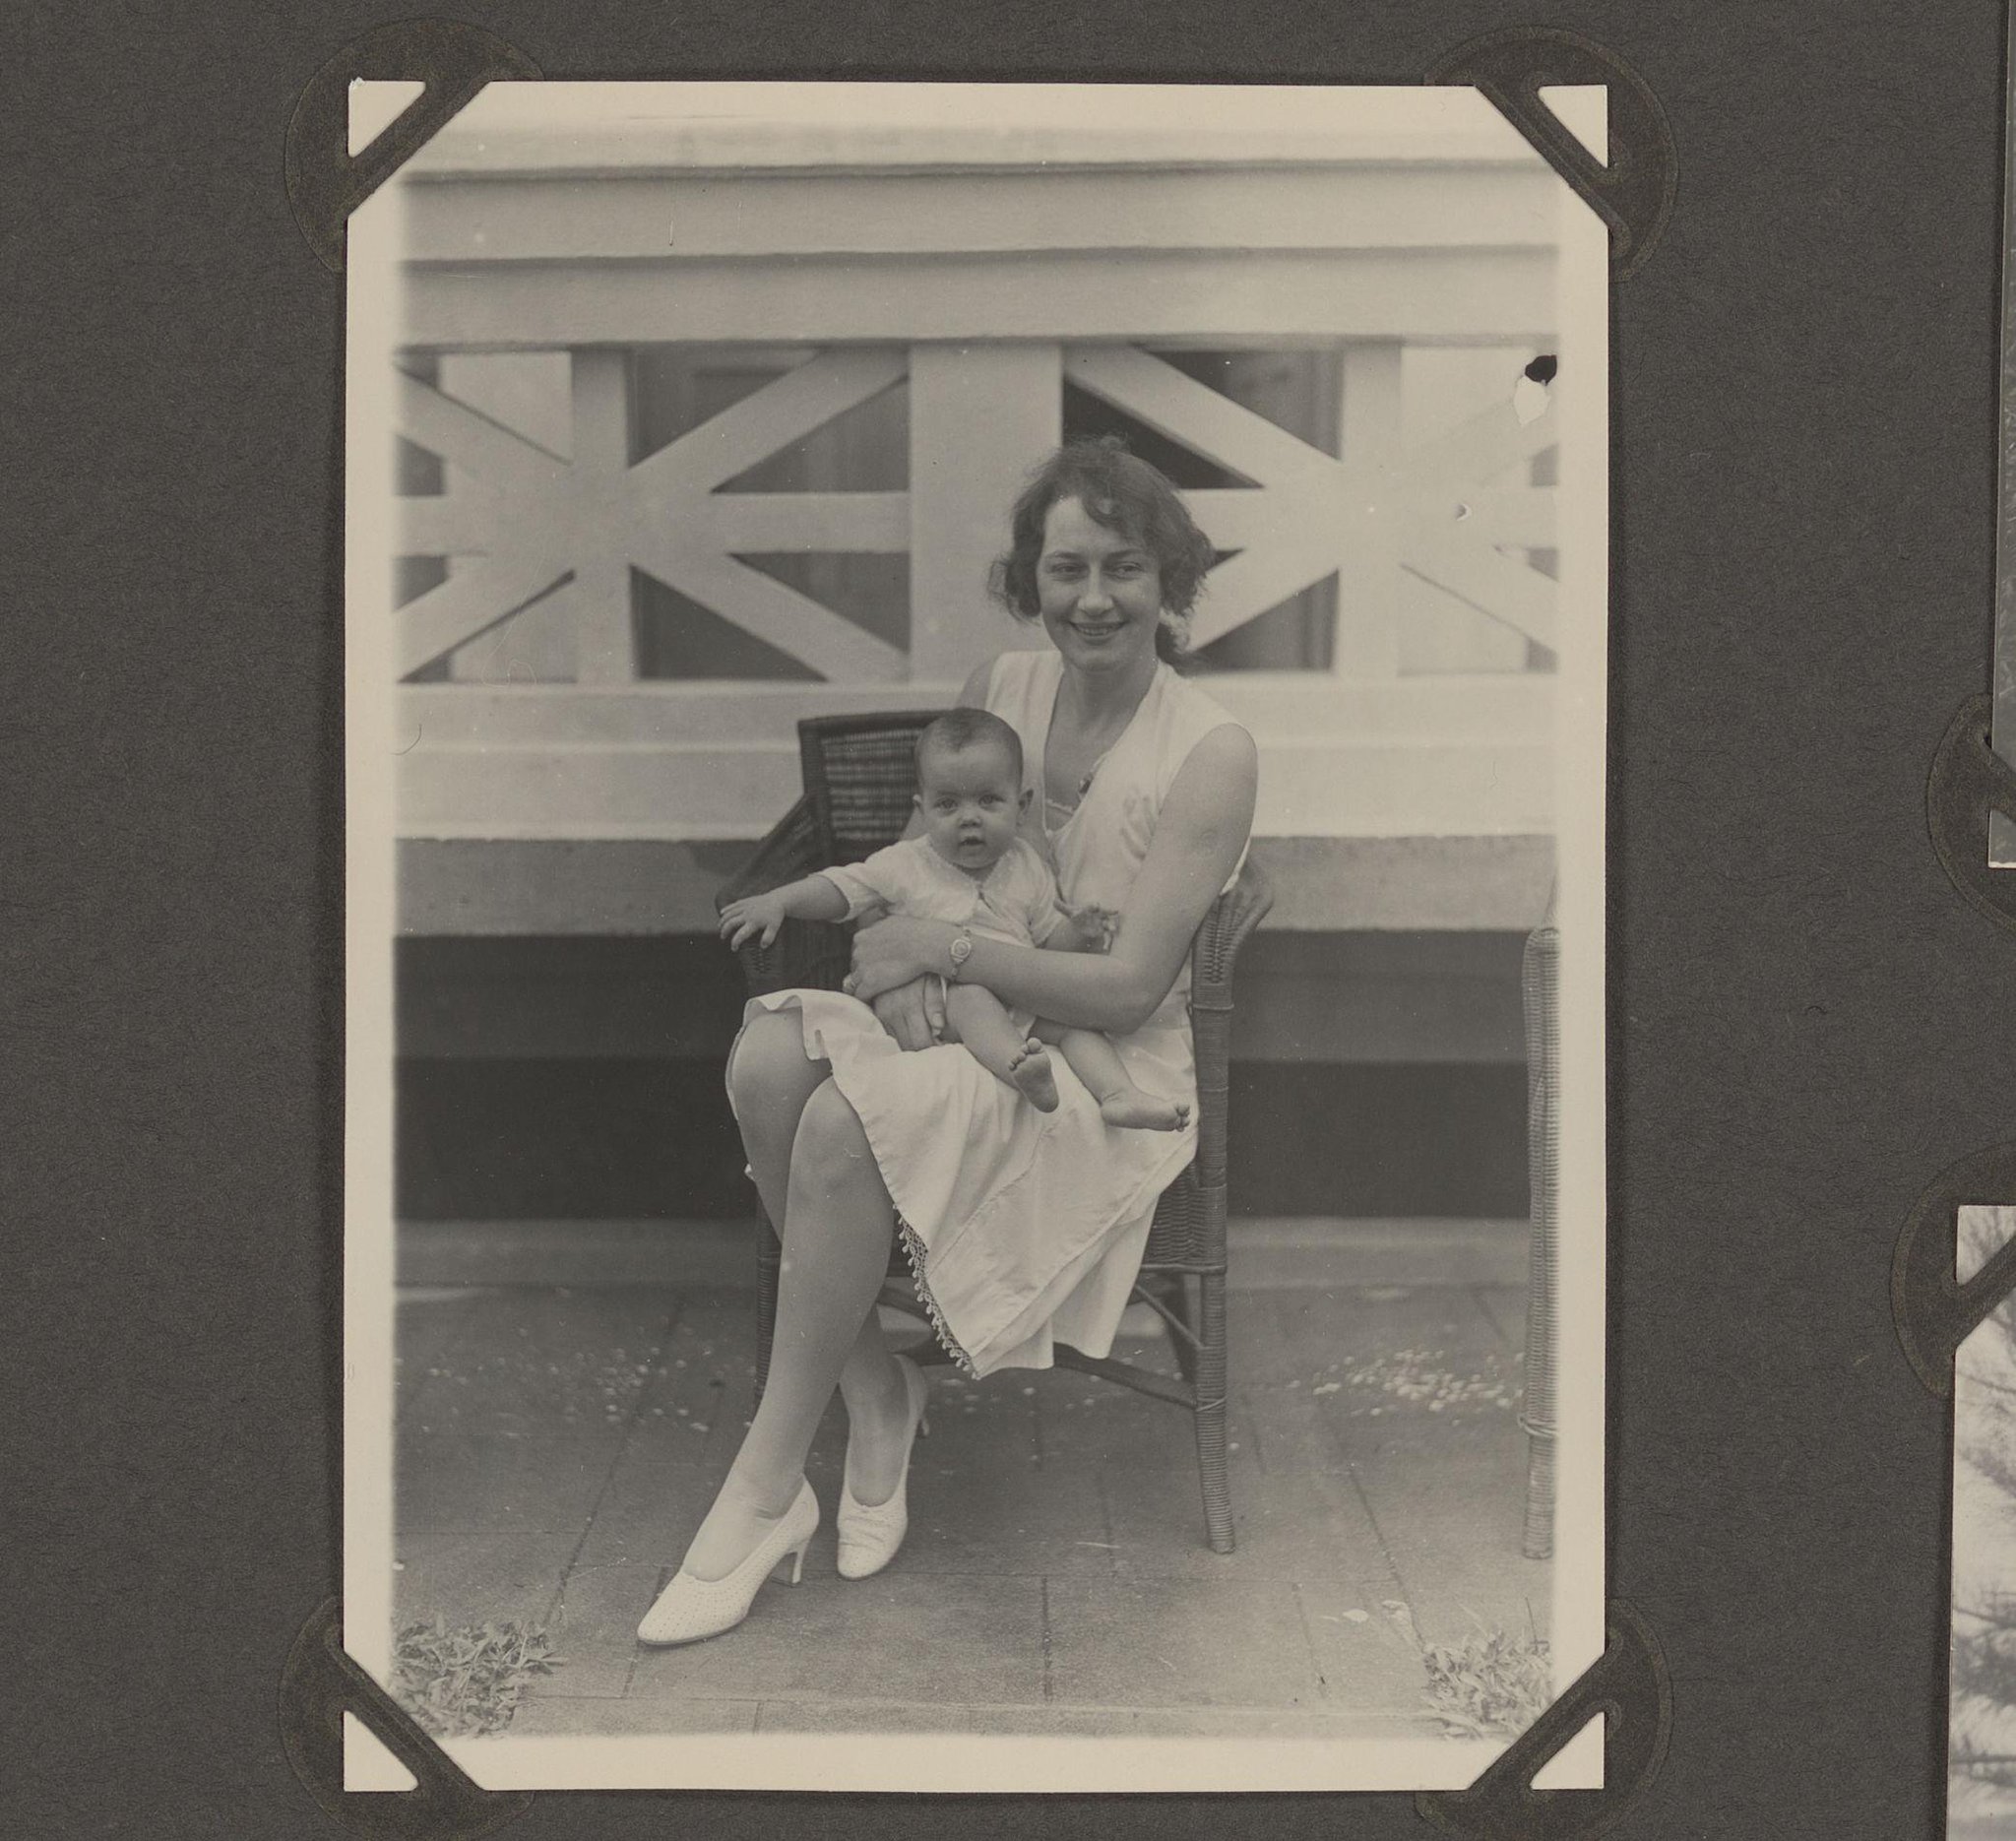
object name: photograph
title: Familiefoto van de kinderen Jetten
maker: Anonymous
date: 1925-1927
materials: photographic support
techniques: photography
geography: suriname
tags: jetten, familie, moengo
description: Familiefoto van de kinderen Jetten met een Nederlandse vrouw. Foto op een bladzijde van een los albumblad. Onderdeel van het ensemble met foto's van de familie van ingenieur Jetten in de mijnbouwstad Moengo in Suriname.